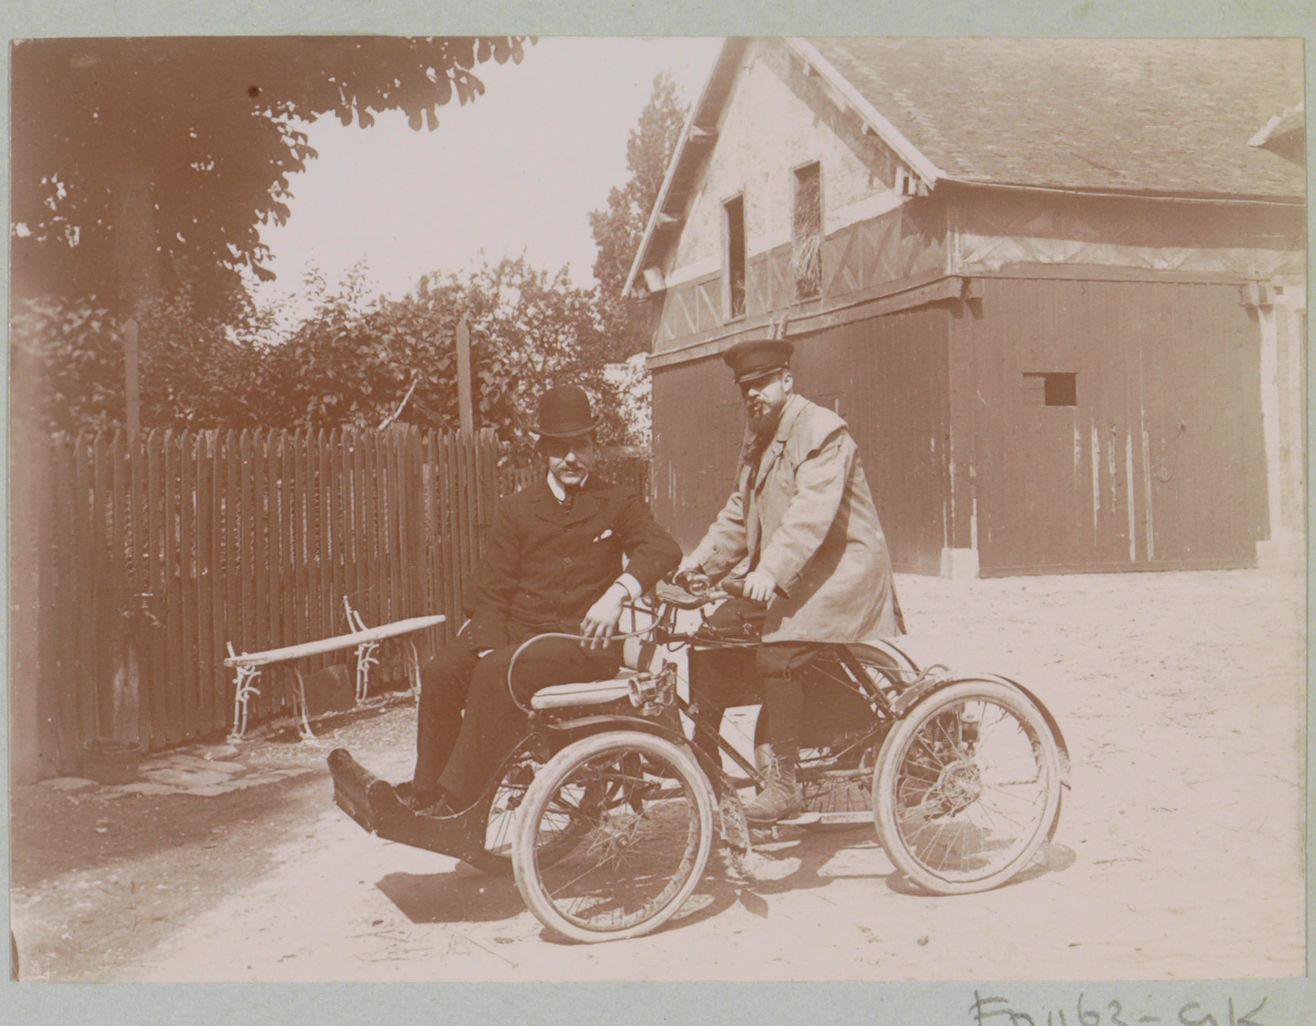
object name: photograph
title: Twee mannen op een gemotoriseerde vierwieler in Frankrijk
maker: delizy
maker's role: manufacturer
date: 1898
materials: paper, photographic support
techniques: gelatin silver print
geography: france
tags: motor-cycles and other two-wheeled motor-vehicles, france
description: Onderdeel van Fotoalbum van een Franse amateurfotograaf met opnames van uitstapjes in Frankrijk, Spanje, België, Luxemburg en Nederland, de eerste automobielen en autoraces.